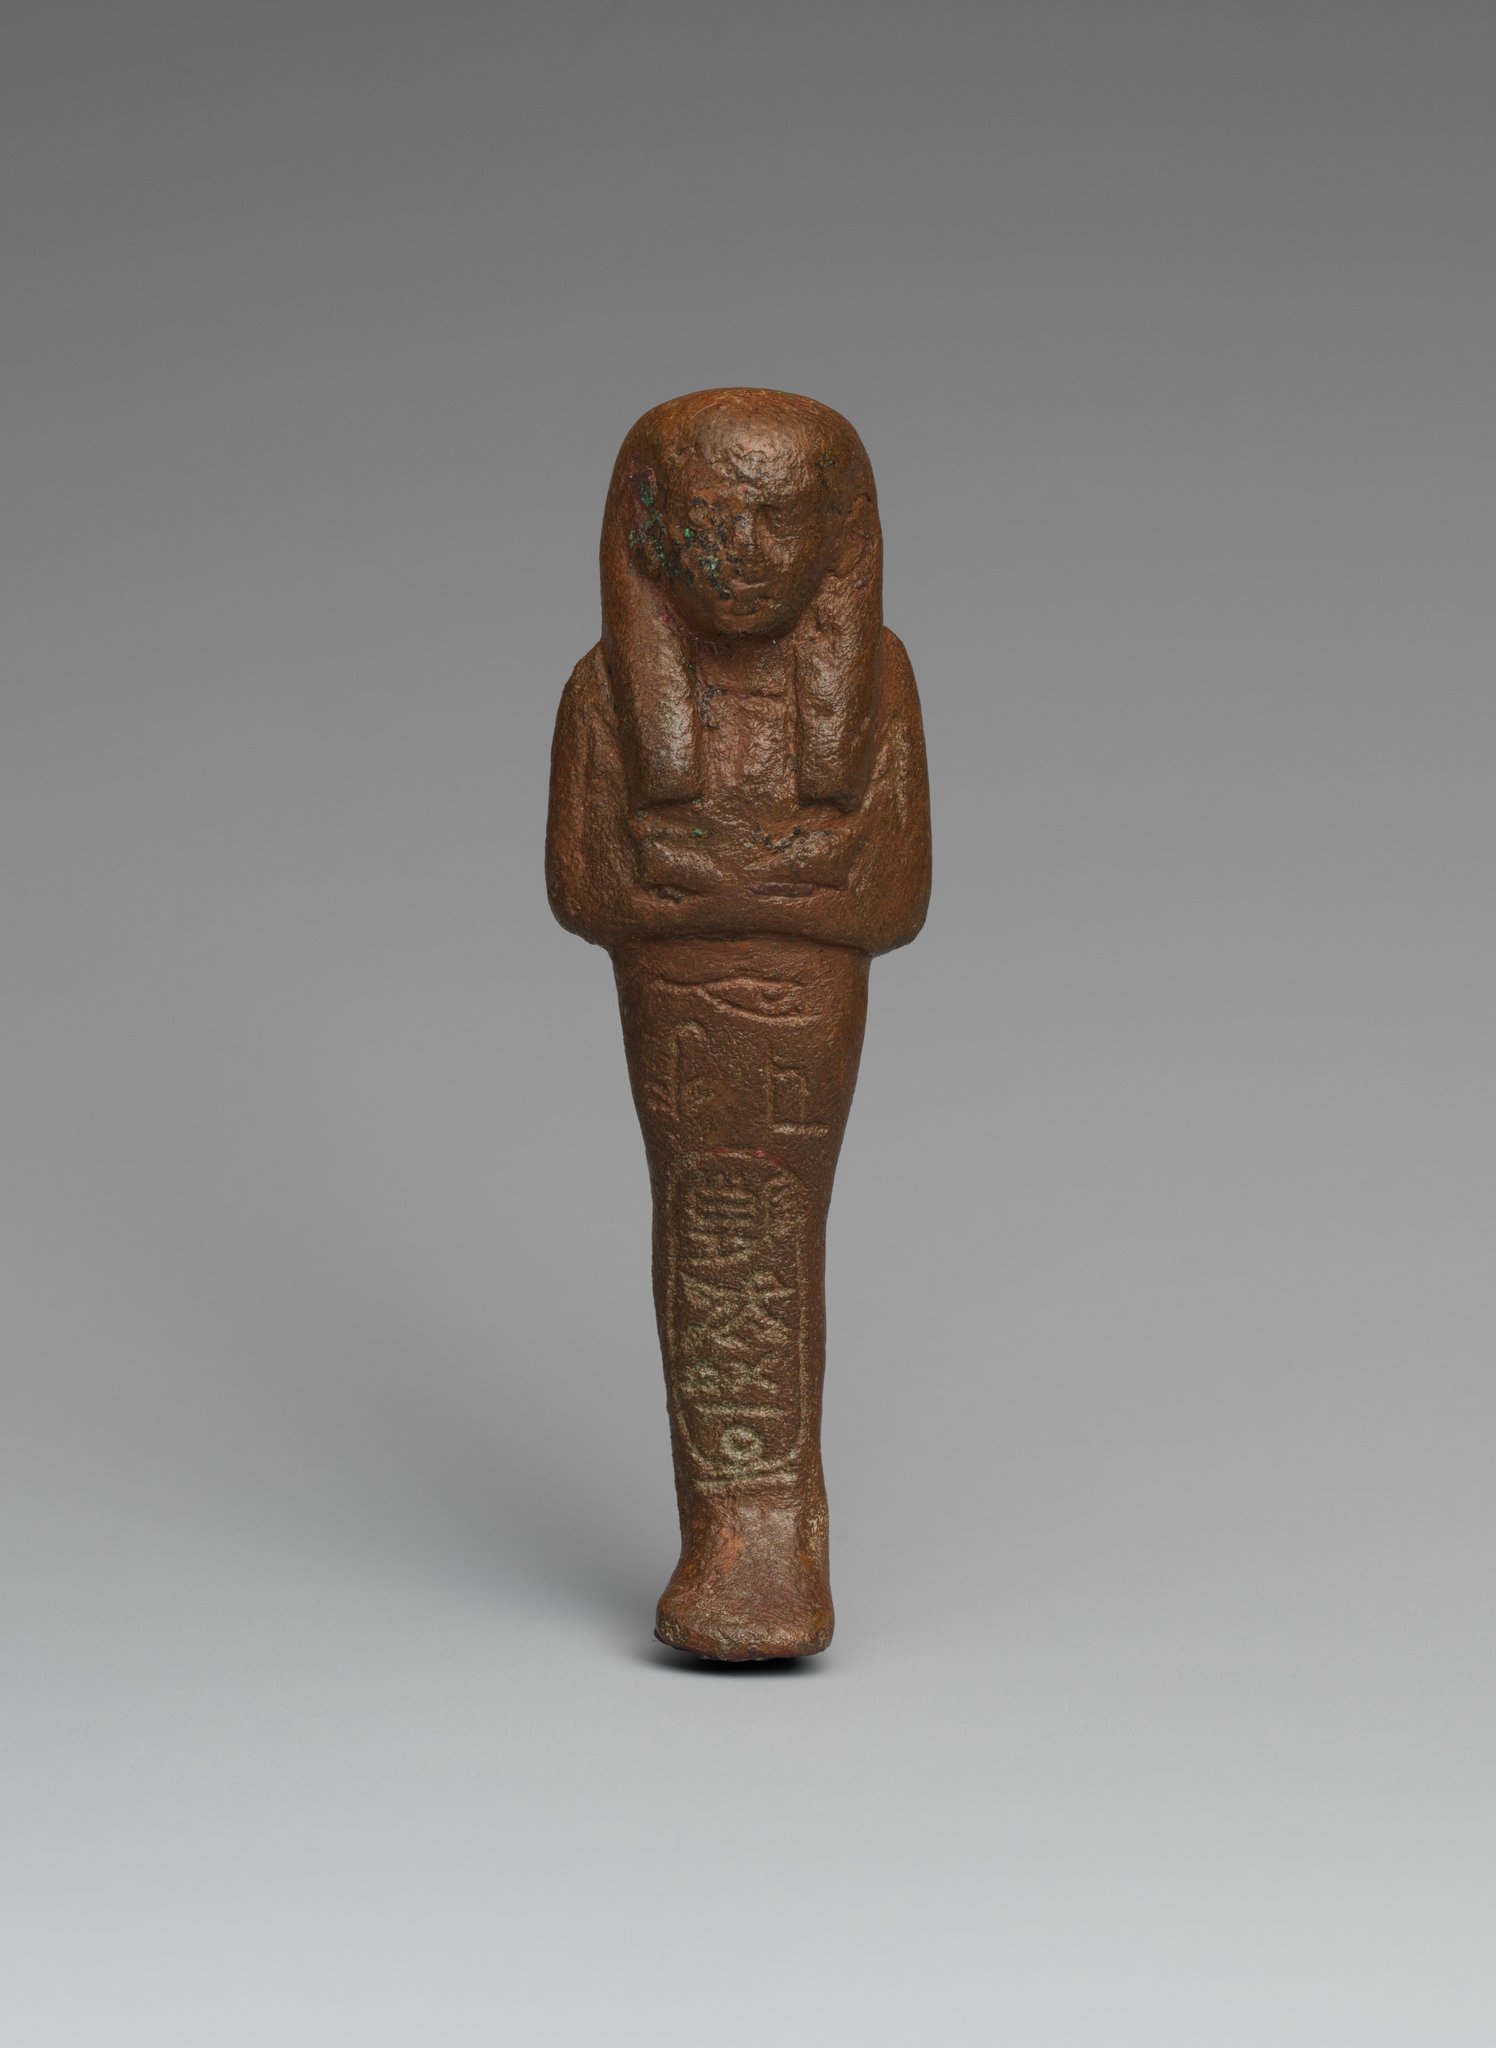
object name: shabti, psusennes i, worker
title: Shabti of Psusennes I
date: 1040-992 BCE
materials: bronze, copper alloy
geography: egypt